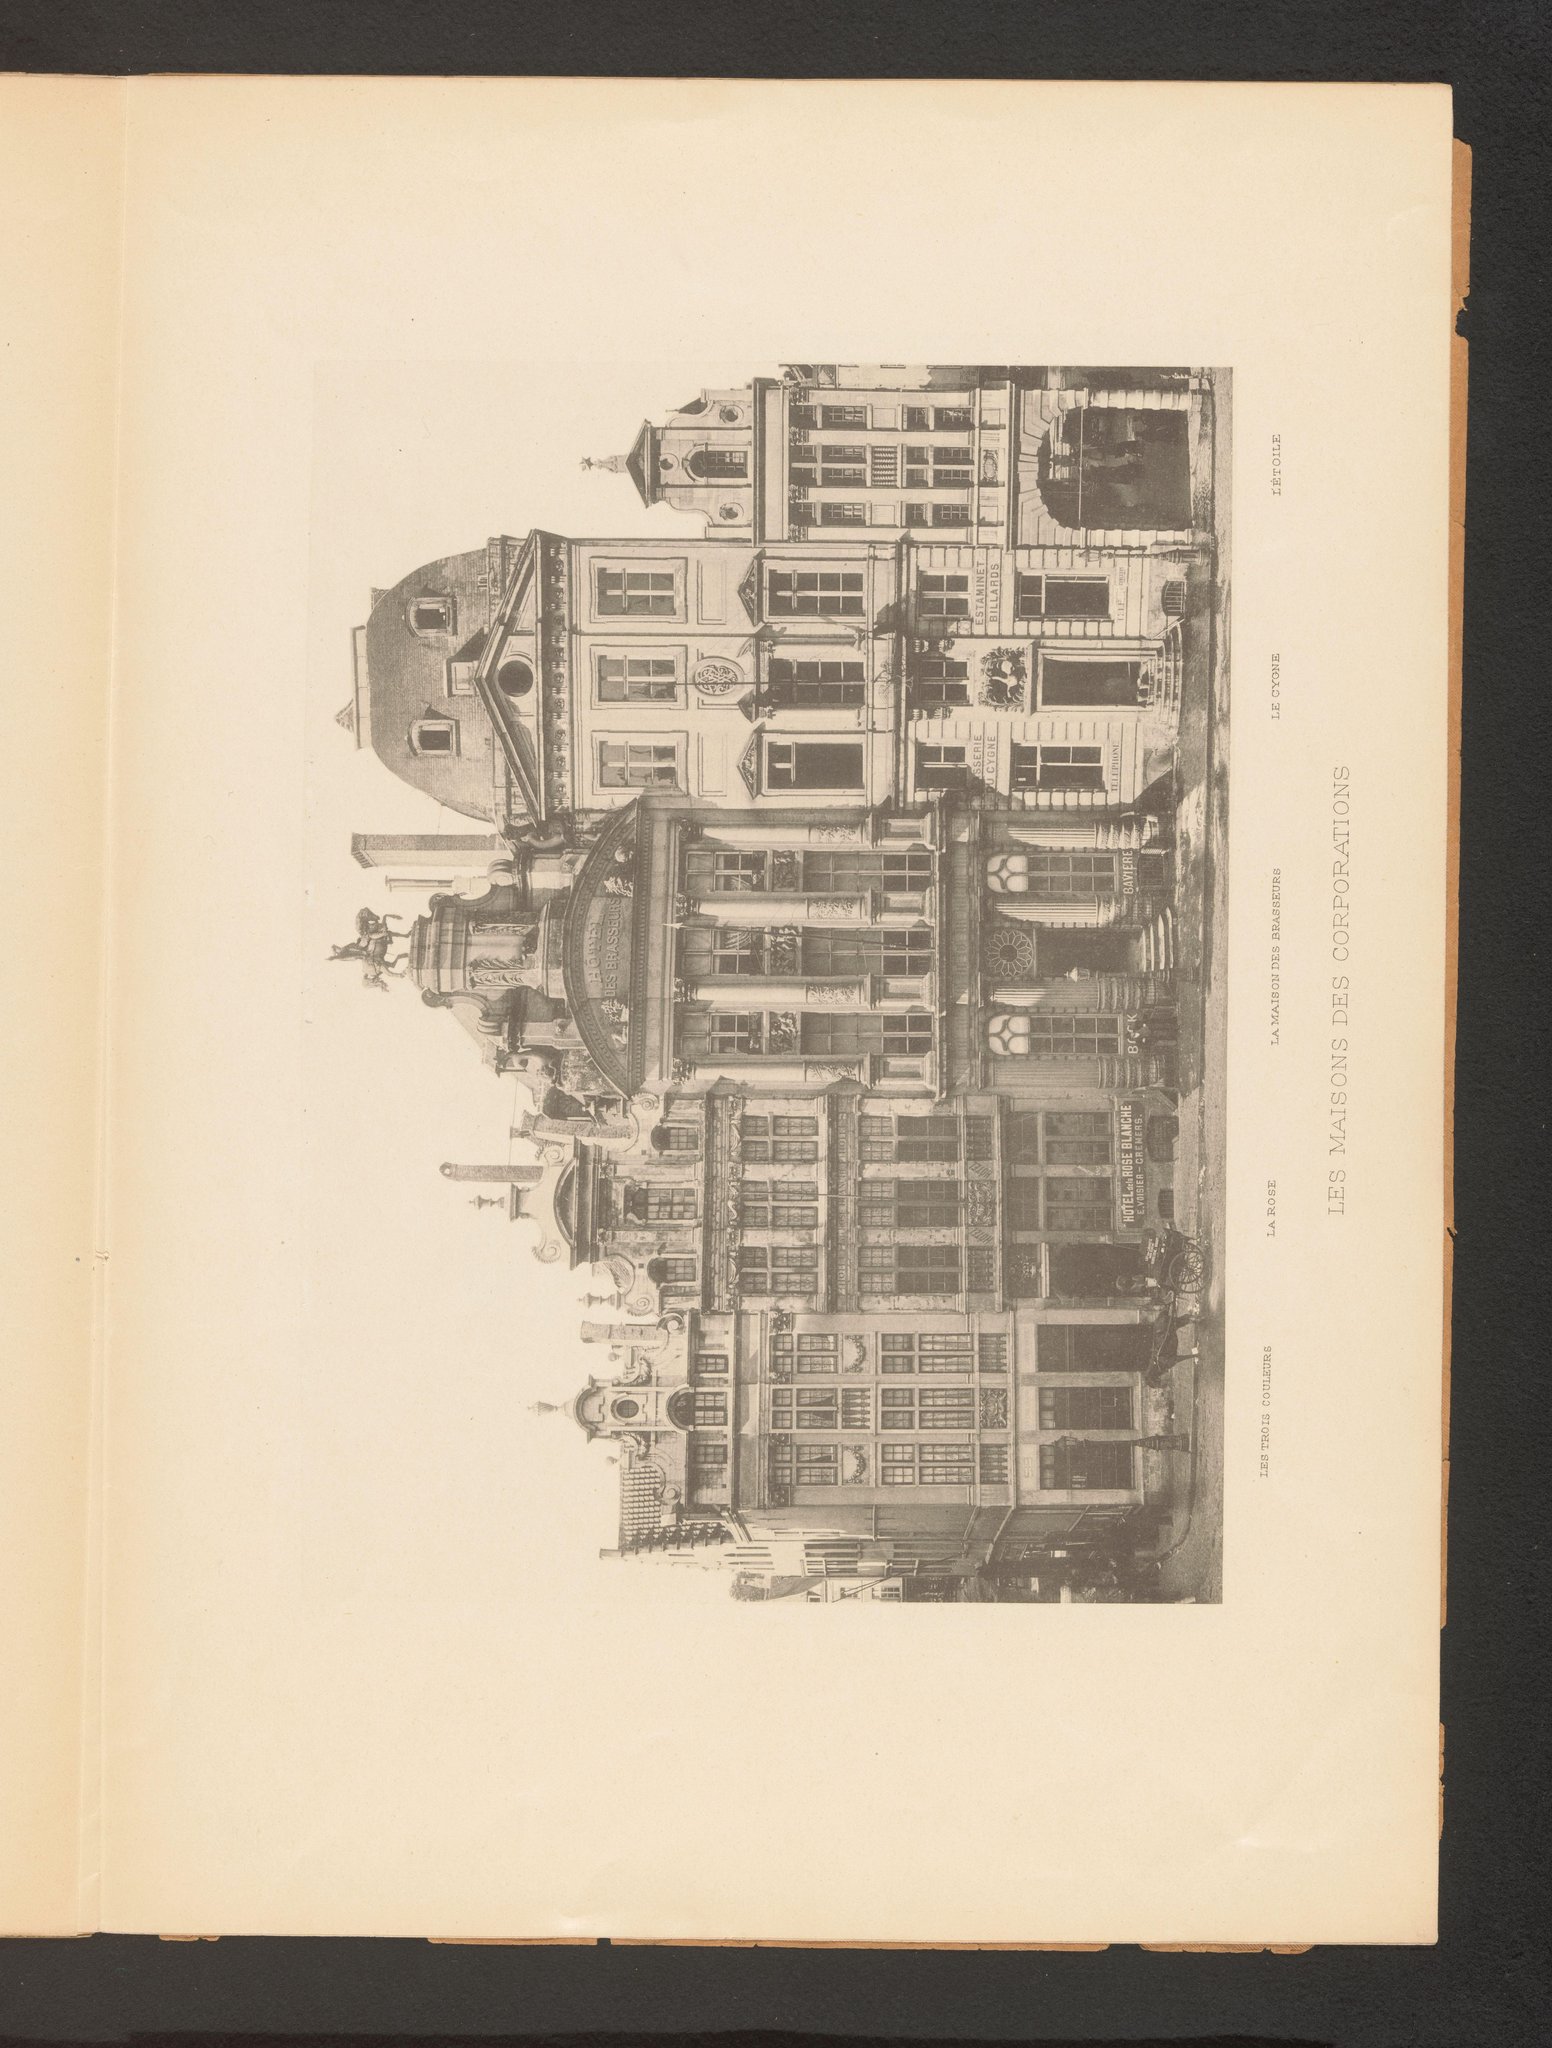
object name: page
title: Les Maisons des Corporations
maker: Anonymous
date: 1894-1899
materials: paper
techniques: photograph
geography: brussels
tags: corporative organization, guild, civic architecture; edifices; dwellings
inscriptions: inscription: ‘Les Trois Couleurs, La Rose, La Maison des Brasseurs, Le Cygne, L'Étoile’